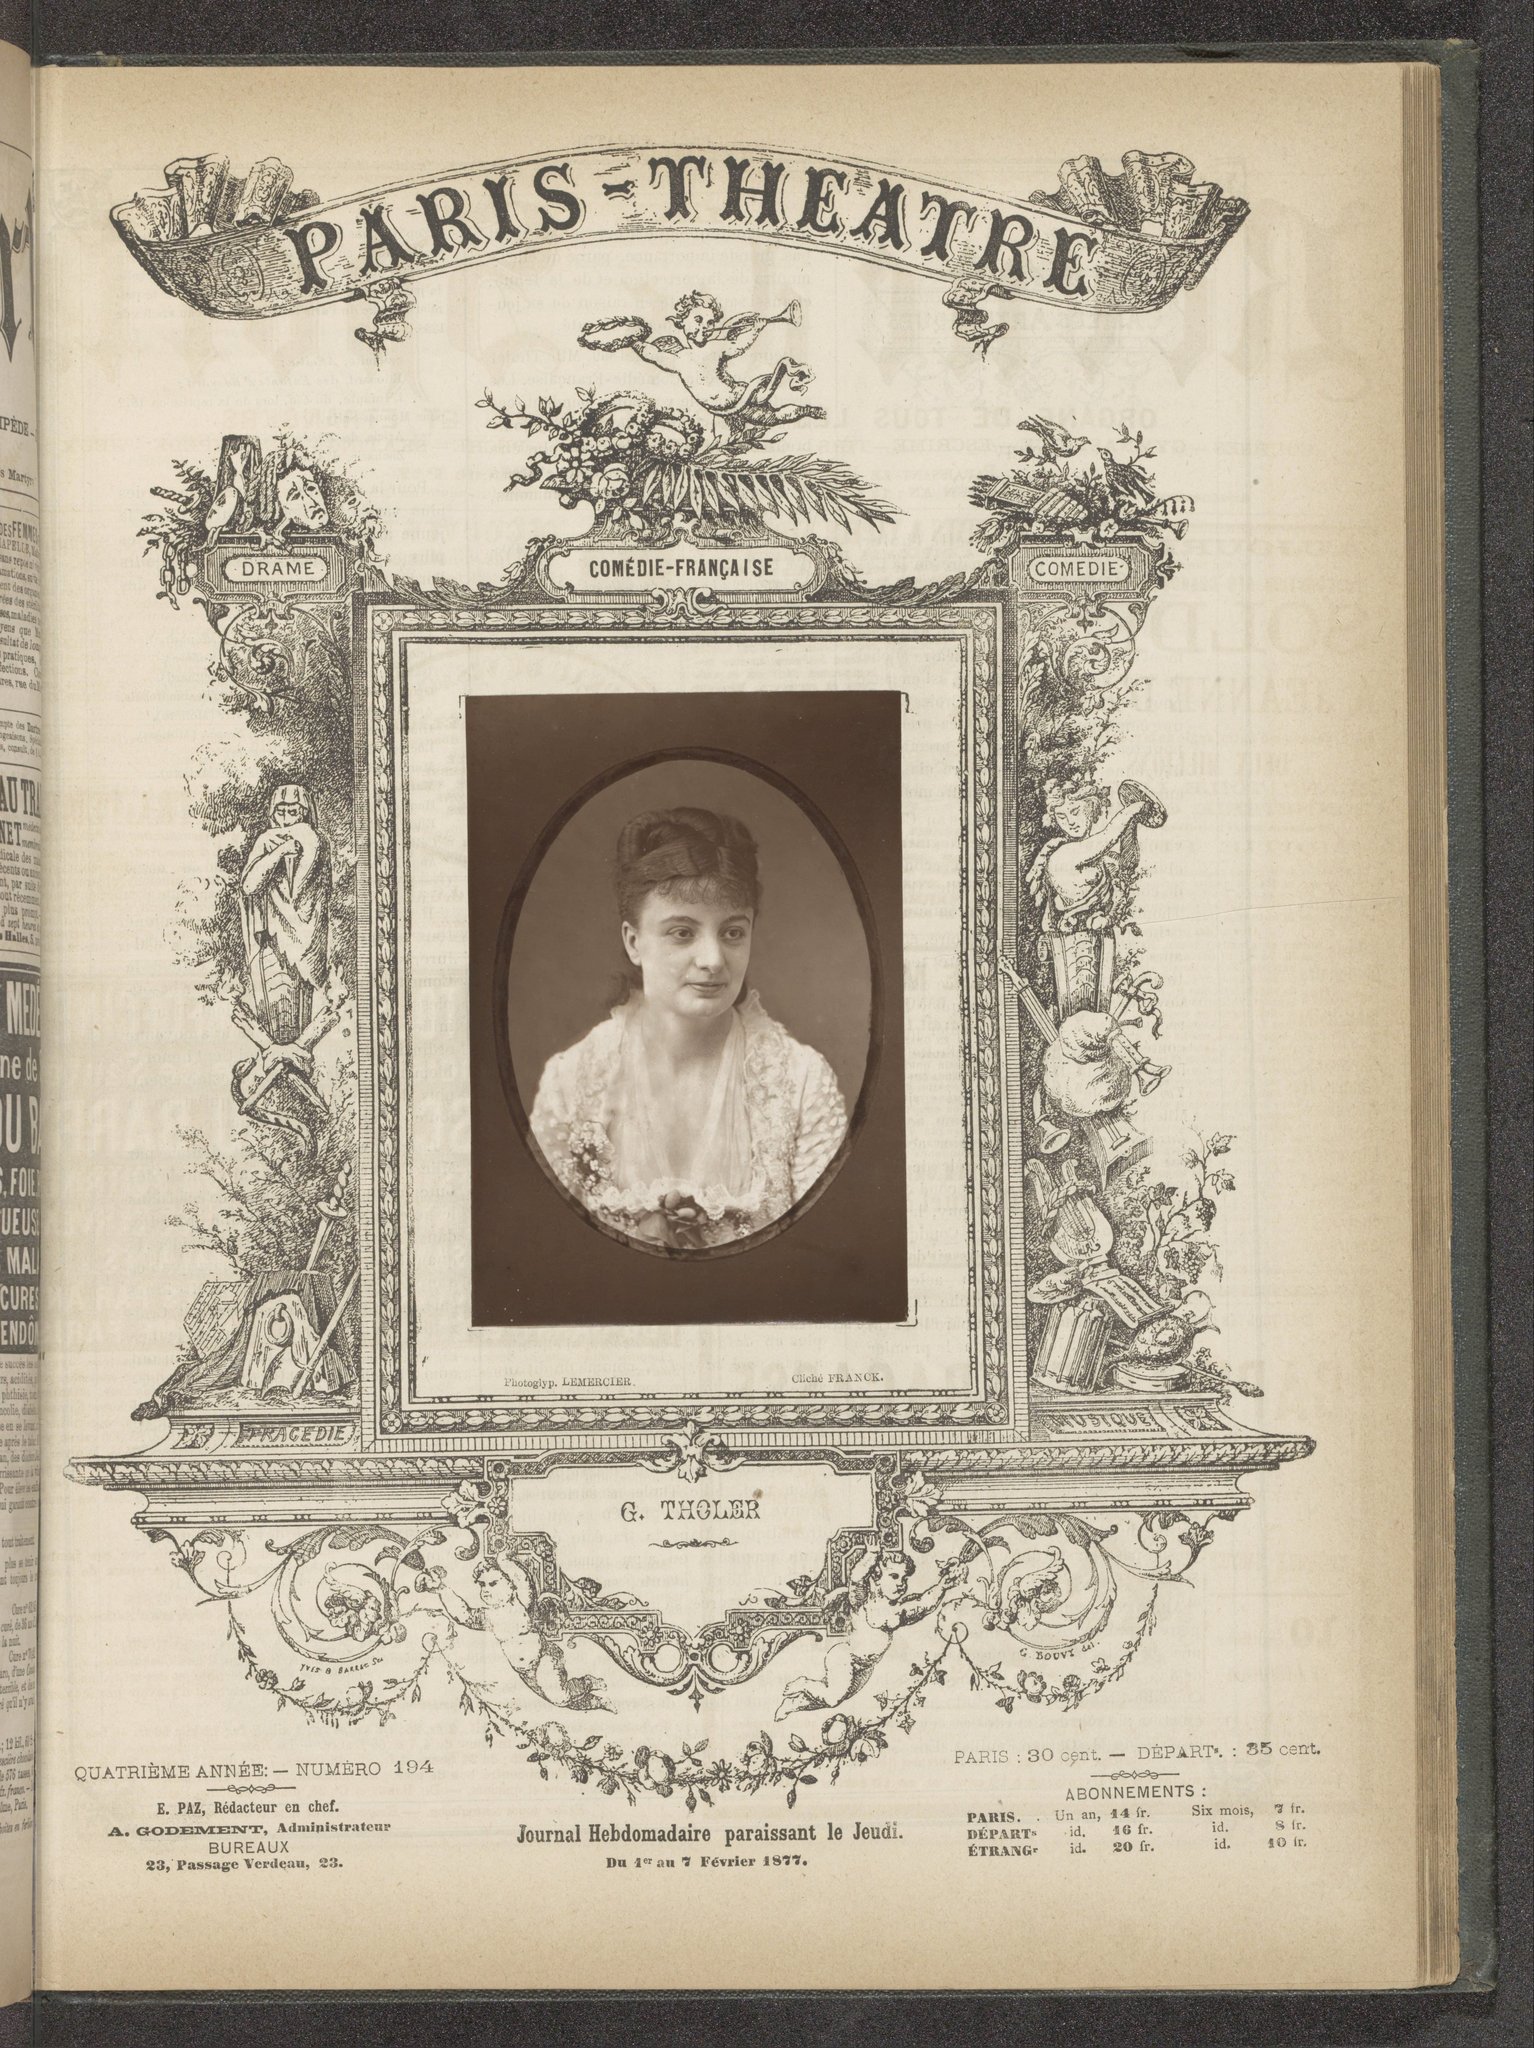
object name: page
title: Portret van Gabrielle Tholer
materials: paper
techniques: woodburytype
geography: france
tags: portrait of actor, actress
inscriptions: inscription: ‘Journal Hebdomadaire paraissant le Jeudi, Du 1er au 7 Février 1877.’, number: ‘Numéro 194’